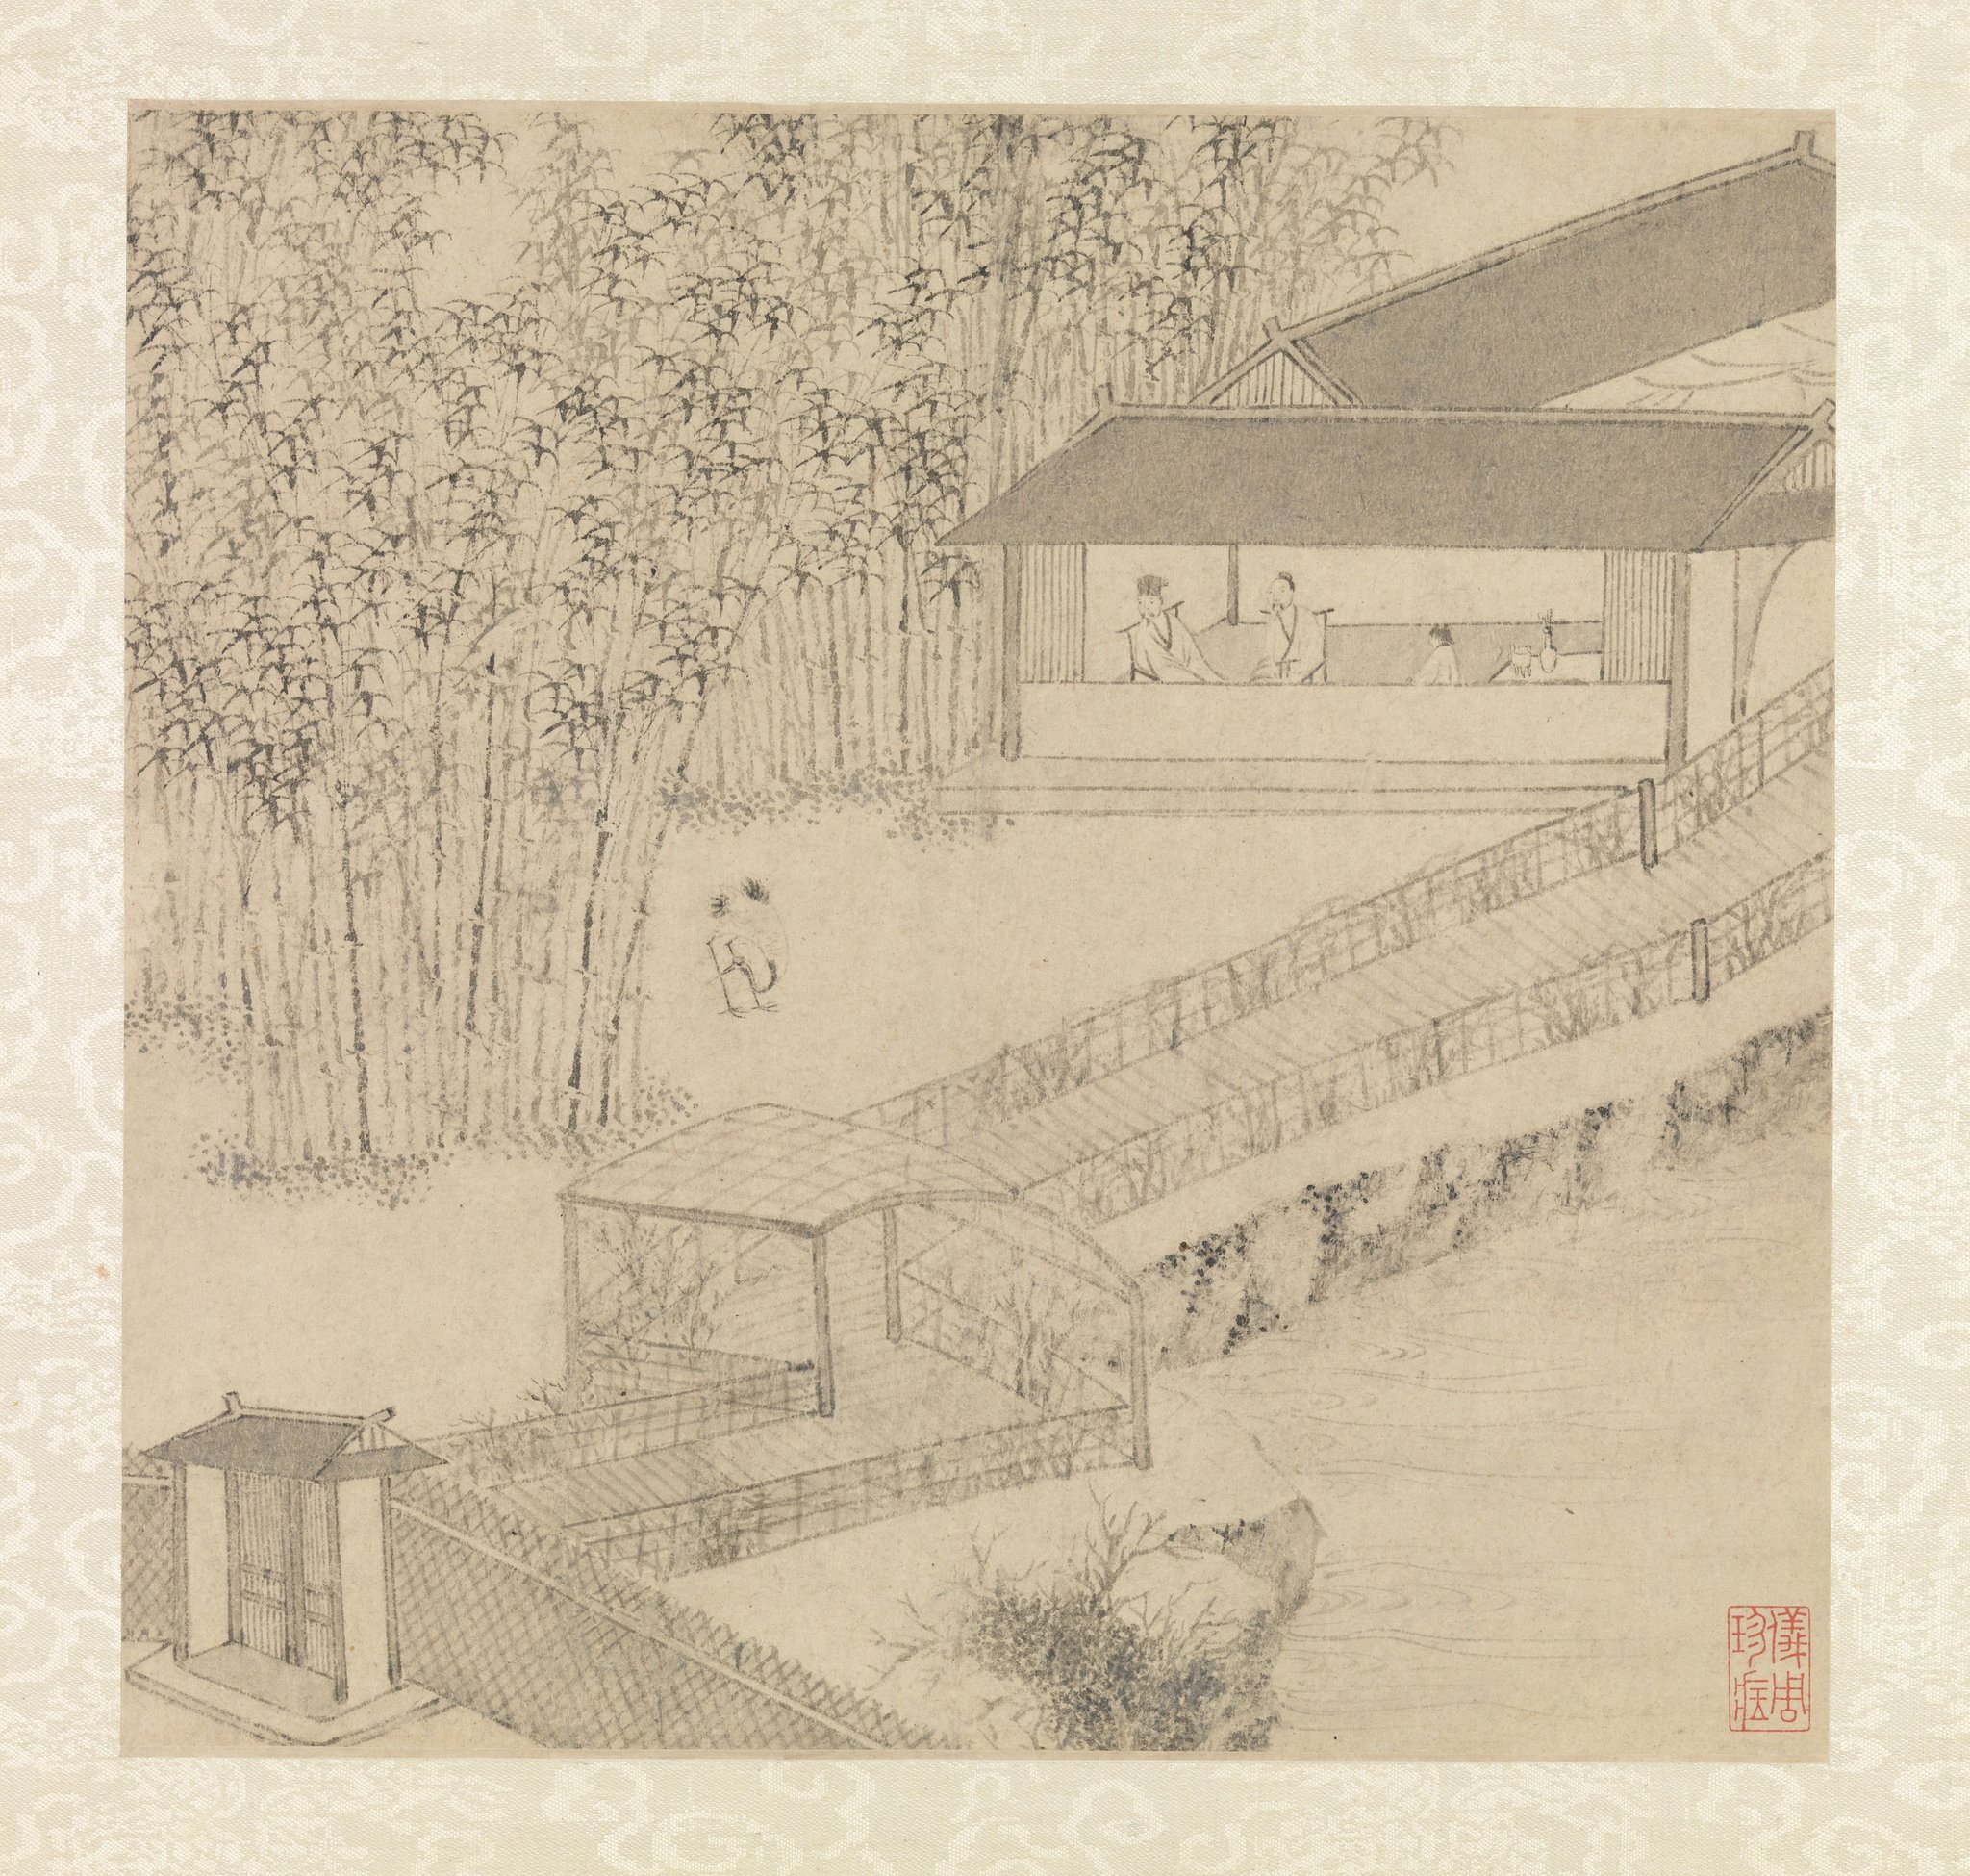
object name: album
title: Garden of the Inept Administrator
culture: chinese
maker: wen zhengming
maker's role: artist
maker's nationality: chinese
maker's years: 1470-1559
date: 1551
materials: ink, paper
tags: gardens